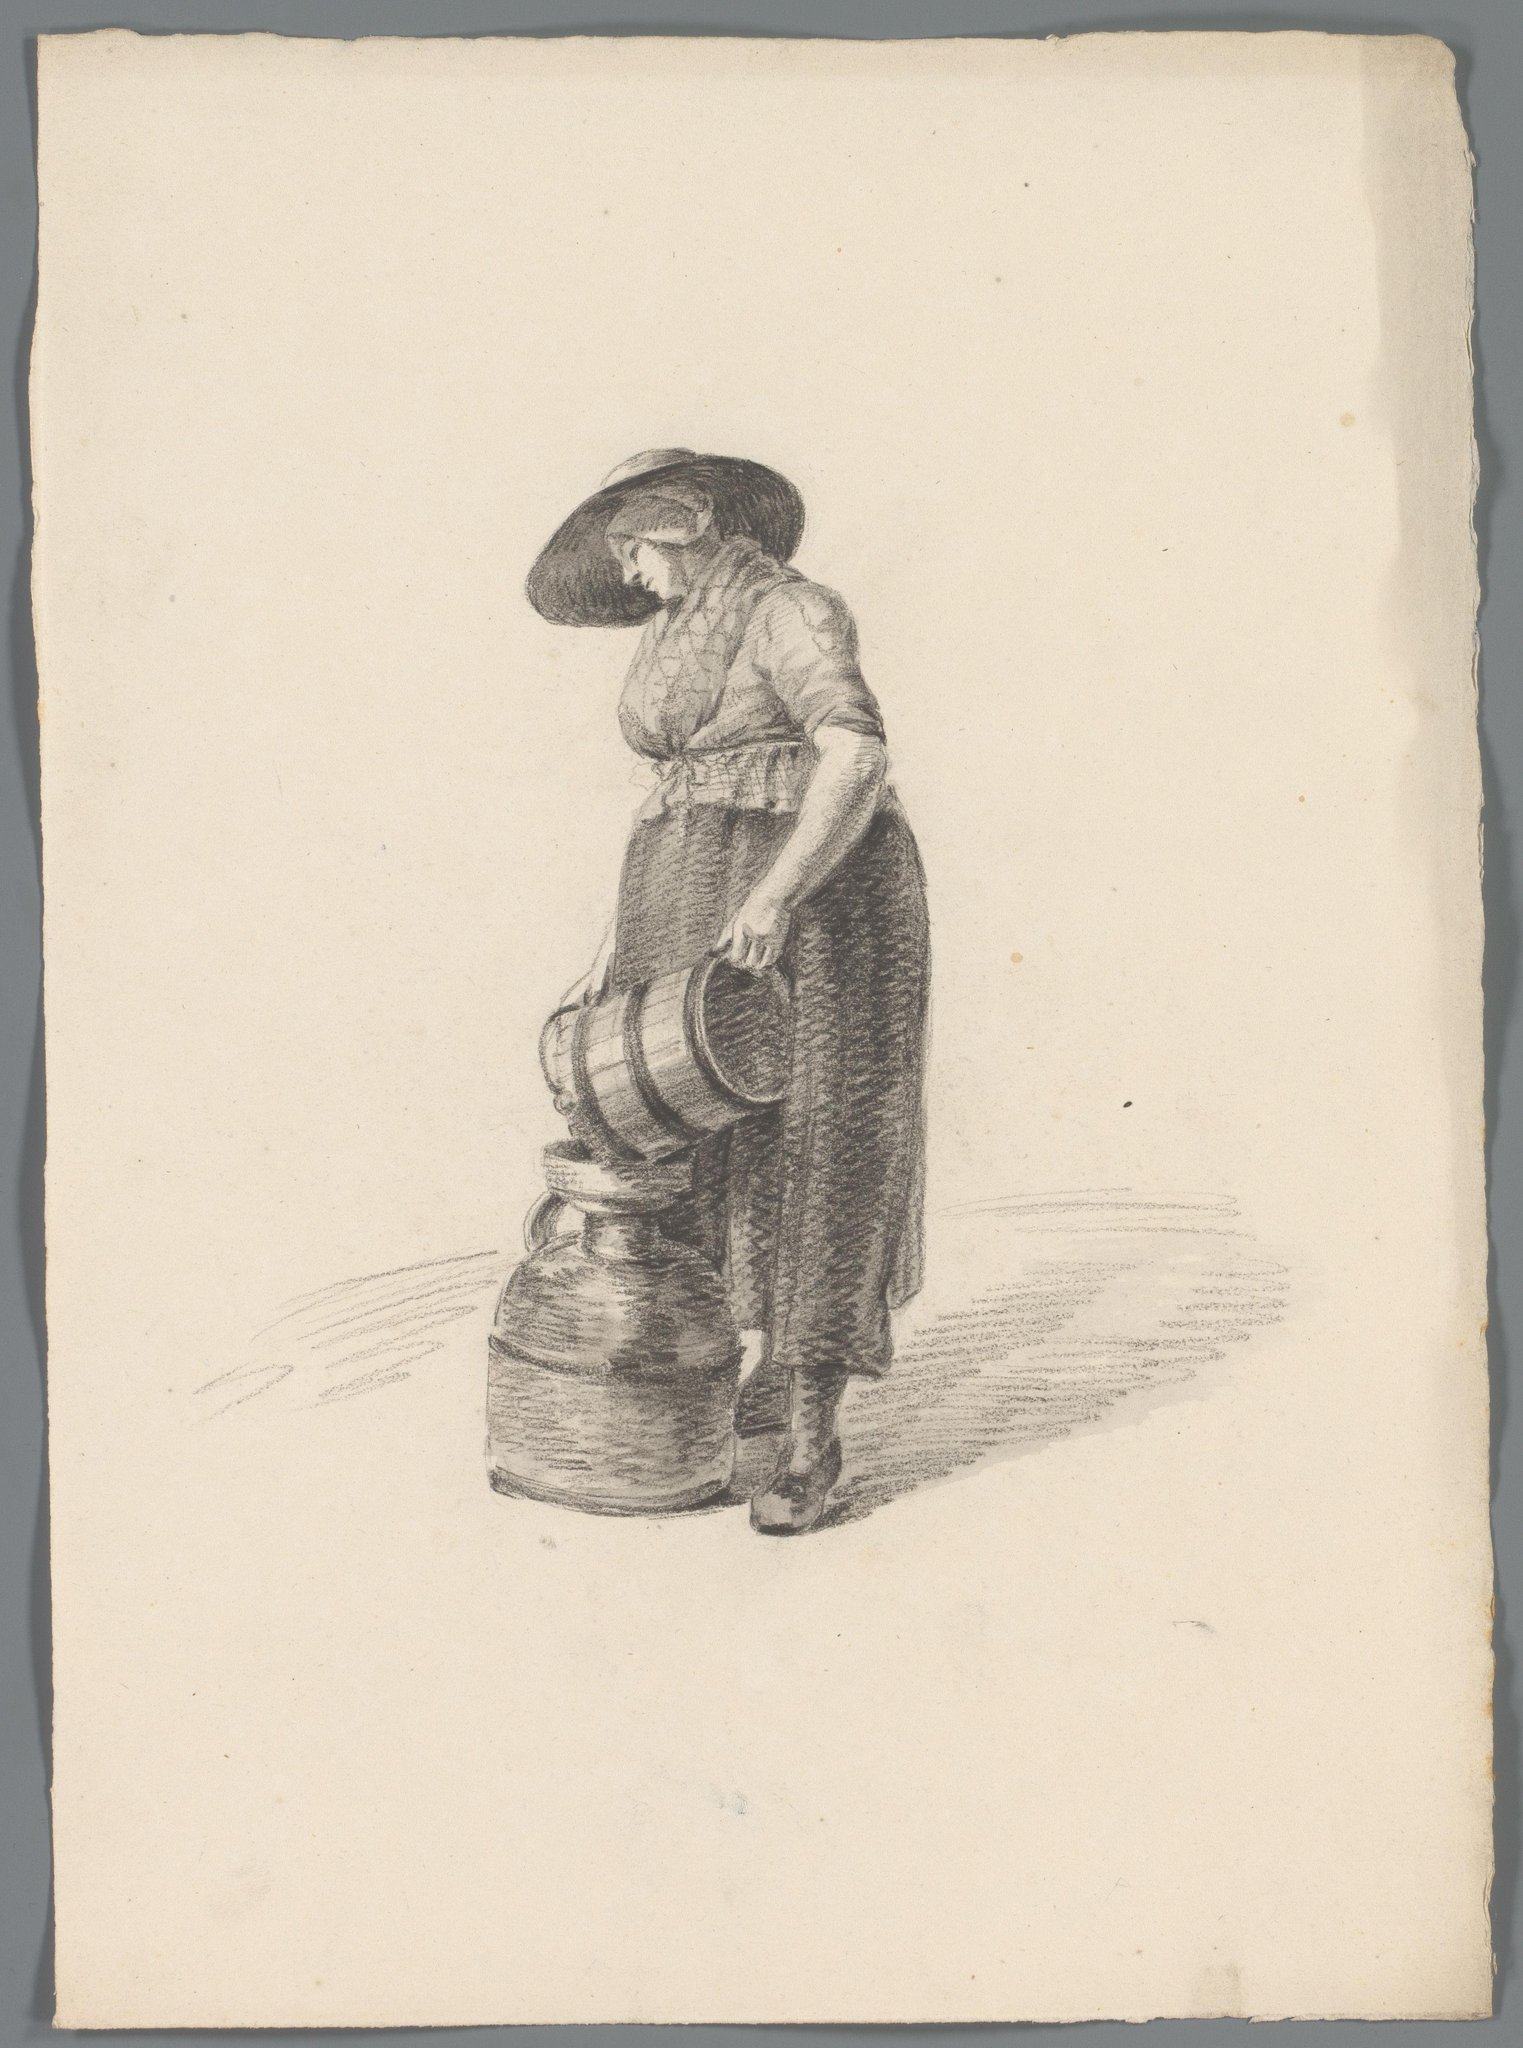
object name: drawing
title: Vrouw giet met een emmer melk in een melkbus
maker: Anonymous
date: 1820-1830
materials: chalk, paper, watercolor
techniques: brush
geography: the hague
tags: adult woman, milkmaid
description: Tekeningen waarschijnlijk ontstaan bij het Haagse kunstgenootschap ‘Tot Nut der Tekenkunst’, waar twee keer per week tekenavonden werden georganiseerd met geklede modellen.